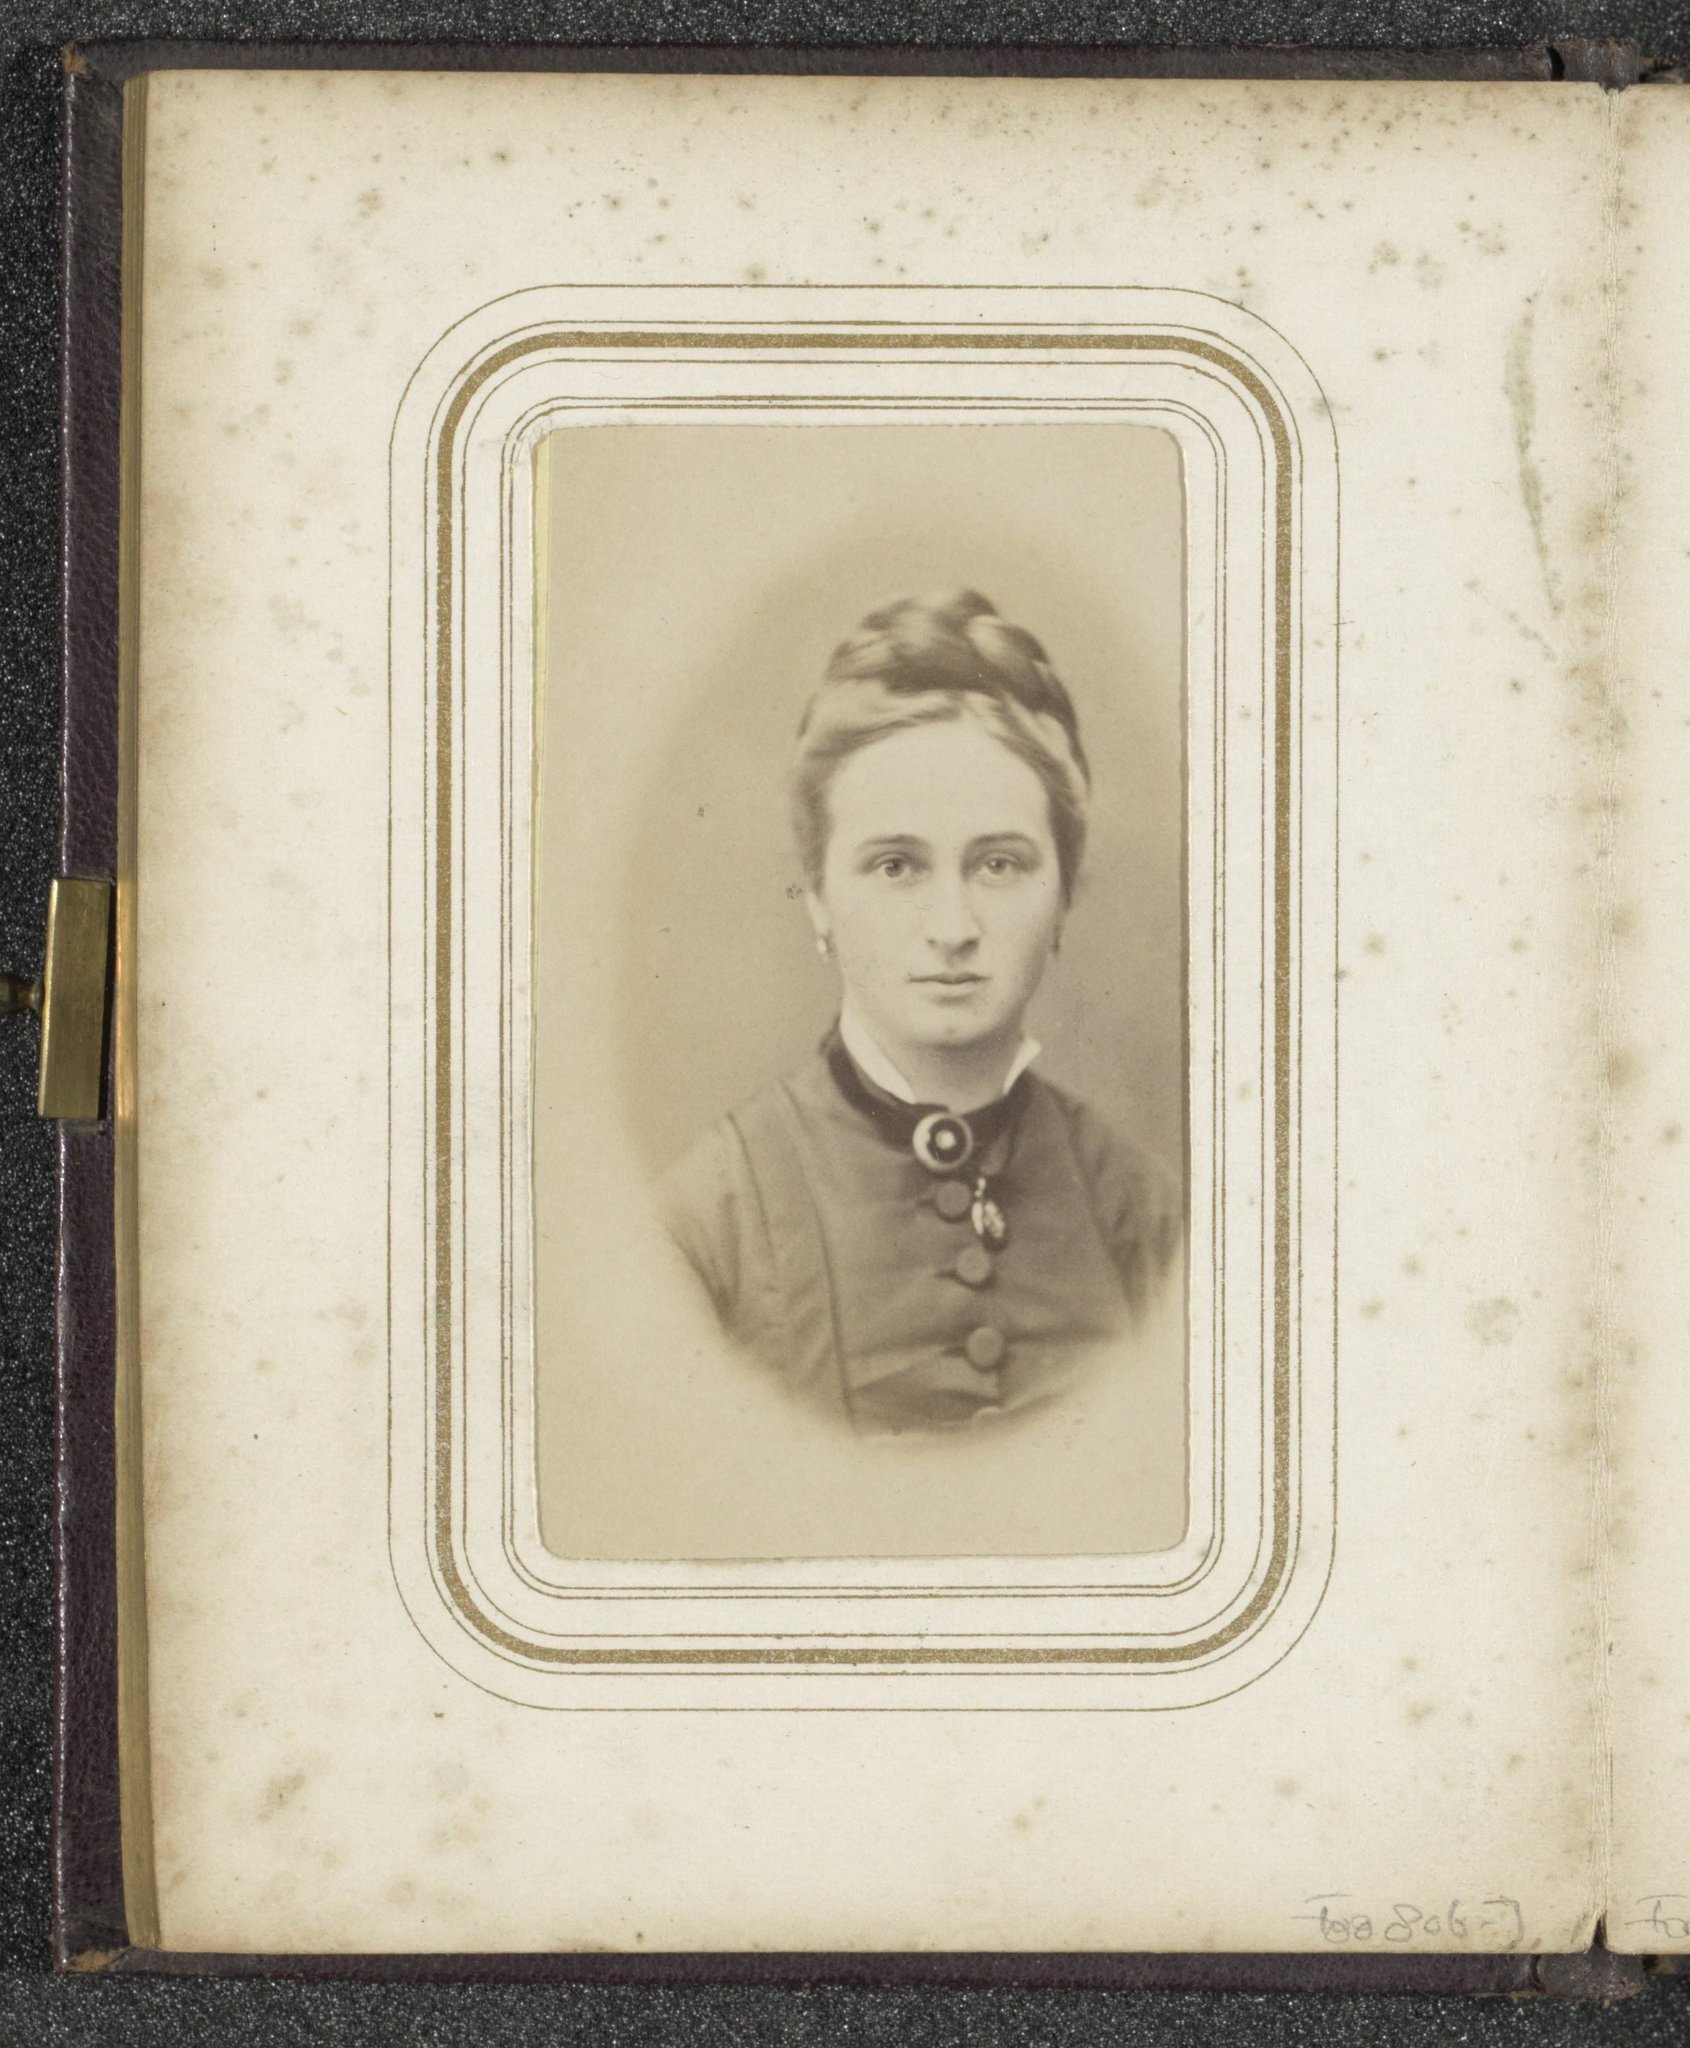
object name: photograph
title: Portret van een vrouw met een opgestoken haarvlecht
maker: hermann günther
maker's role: fotograaf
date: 1868-1890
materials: cardboard, paper, photographic support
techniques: albumen print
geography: hannover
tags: historical persons, styles of hairdress - aa - ~ women, clothing for the upper part of the body, border, ribbon, braid, necklace, ear-rings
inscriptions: address: ‘Hannover Marien-Strasse No. 7.’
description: Onderdeel van Fotoalbum met 36 cartes-de-visite van Nederlandse personen.